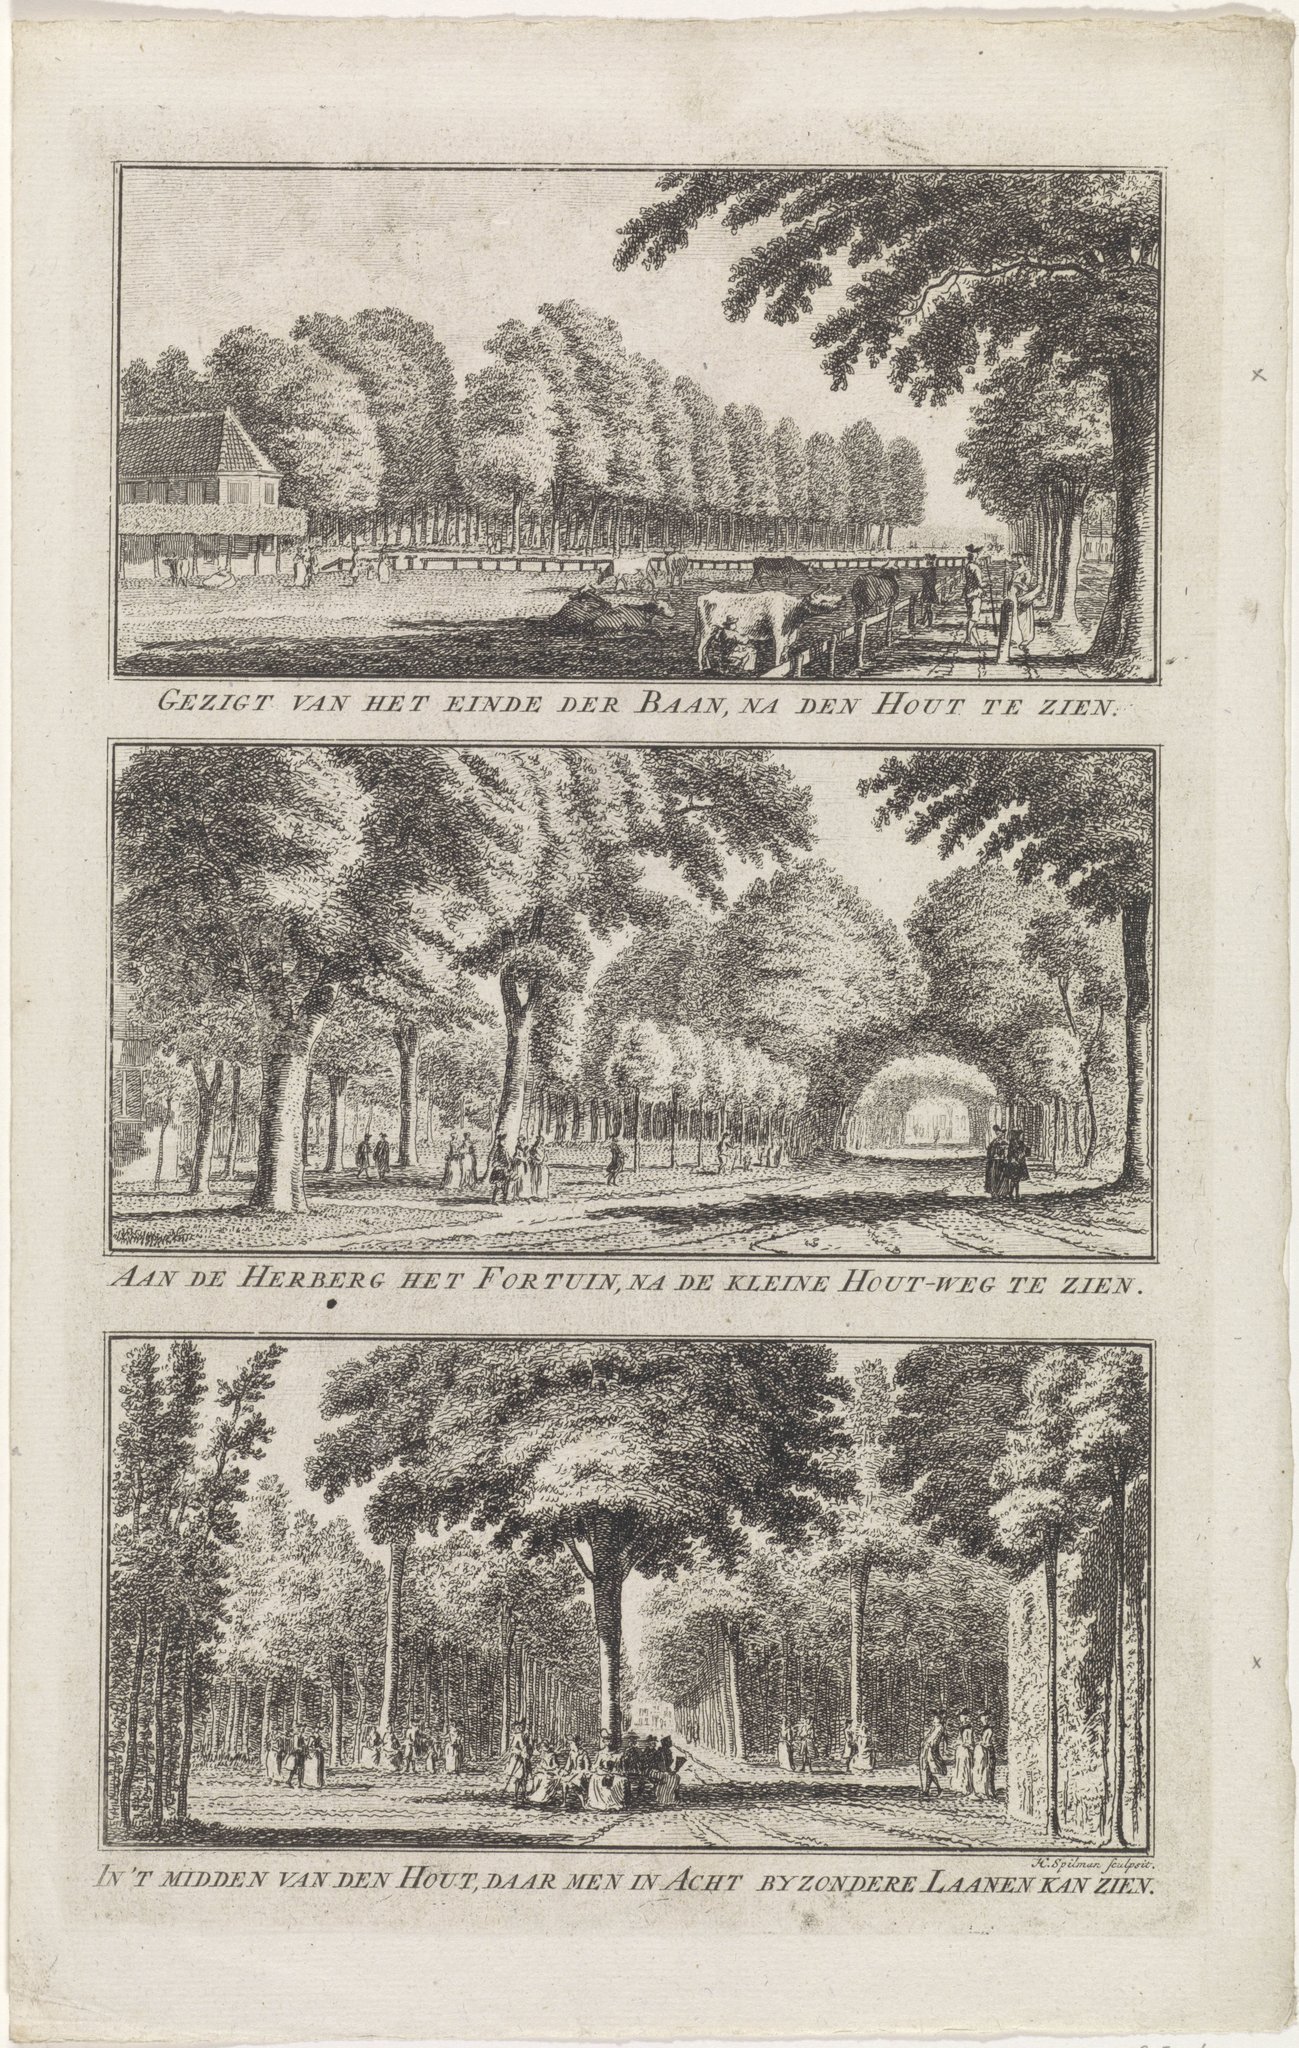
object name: book illustration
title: Gezichten in de vermakelijke landsdouwen van Haarlem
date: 1763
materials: paper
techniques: etching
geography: haarlem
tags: trees, open-air recreation, lane, alley, haarlem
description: Prent gebruikt in: Verzaameling van 66 aangenaame gezichten in de vermakelyke landsdouwen van Haarlem, nieuwlings naar 't leeven getekend door de beroemde konstenaars H. Spilman en C.V. Noorde : nevens eene afbeelding van het laatst angelegde Bosch in het Haarlemsche Hout. Haarlem: J. Bosch, 1763.